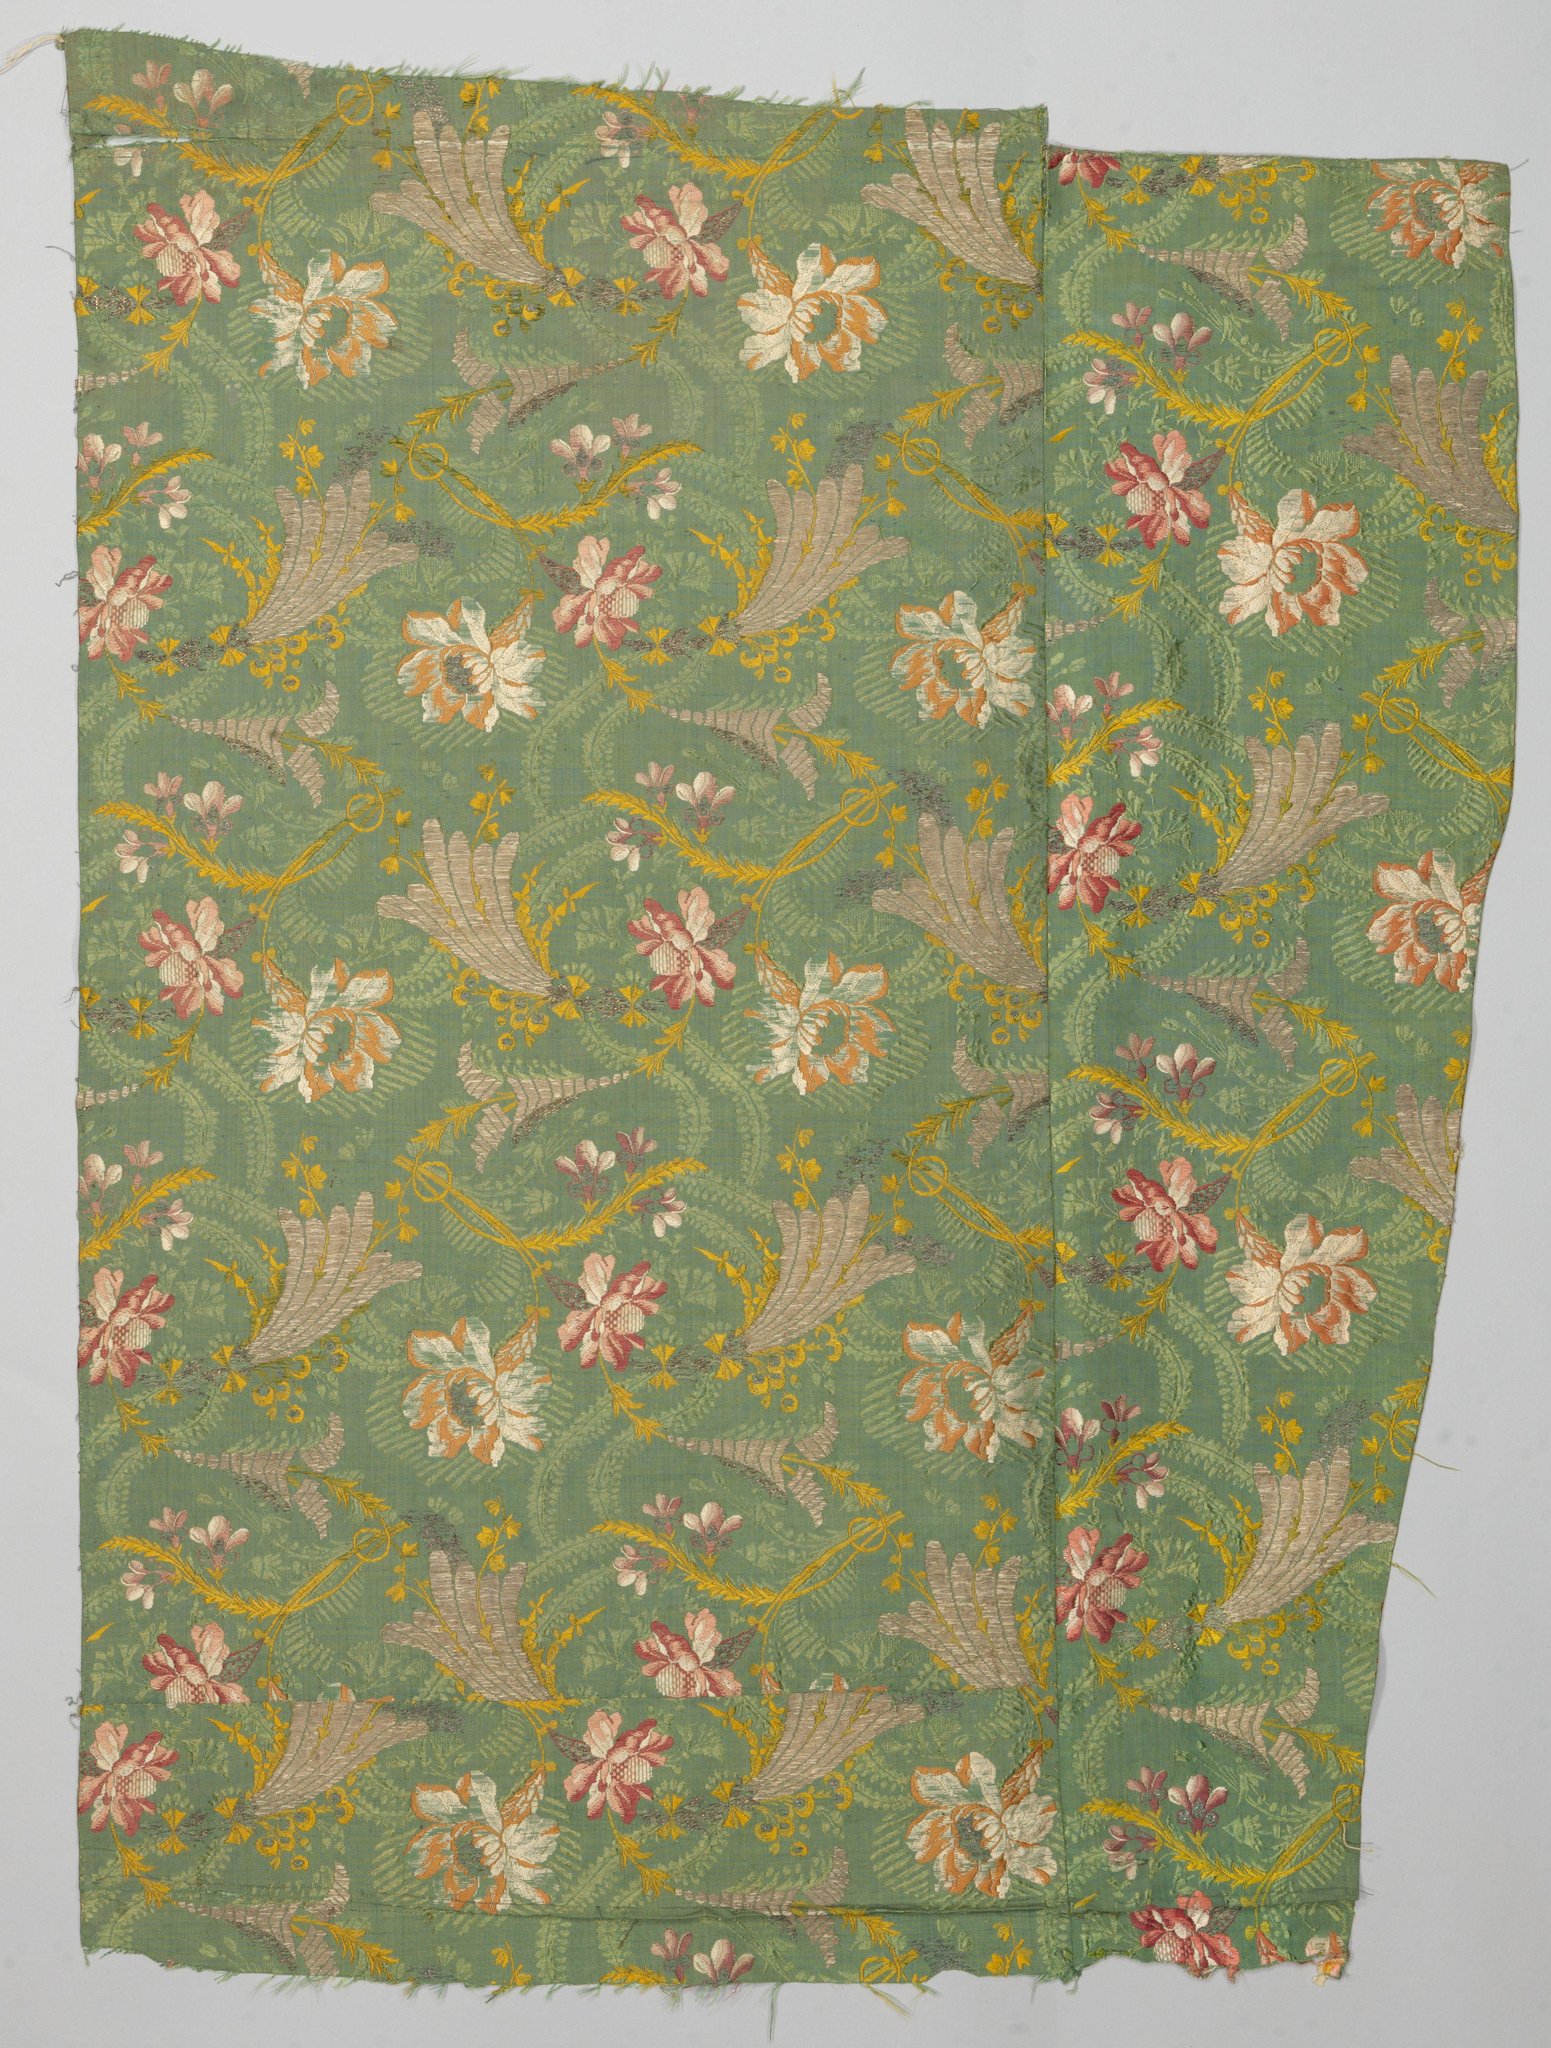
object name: silk textile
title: Fragment gebrocheerde Gros de Tours met liseré-effect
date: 1715-1720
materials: silk, thread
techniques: brocade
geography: france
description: Fragment gebrocheerde Gros de Tours met liseré-effect, bestaande uit drie aan elkaar genaaide fragmenten. Dessin: verticale zigzagbloem- en bladranken in diverse kleuren roze en oker op een gele stam, waarvan telkens twee bladeren in zilver een bizar karakter hebben, op een groen fond met liseré-effect. Opgespeld papiertje met de letter E. zalm, roze en wit in tussenruimten op een roze fond.